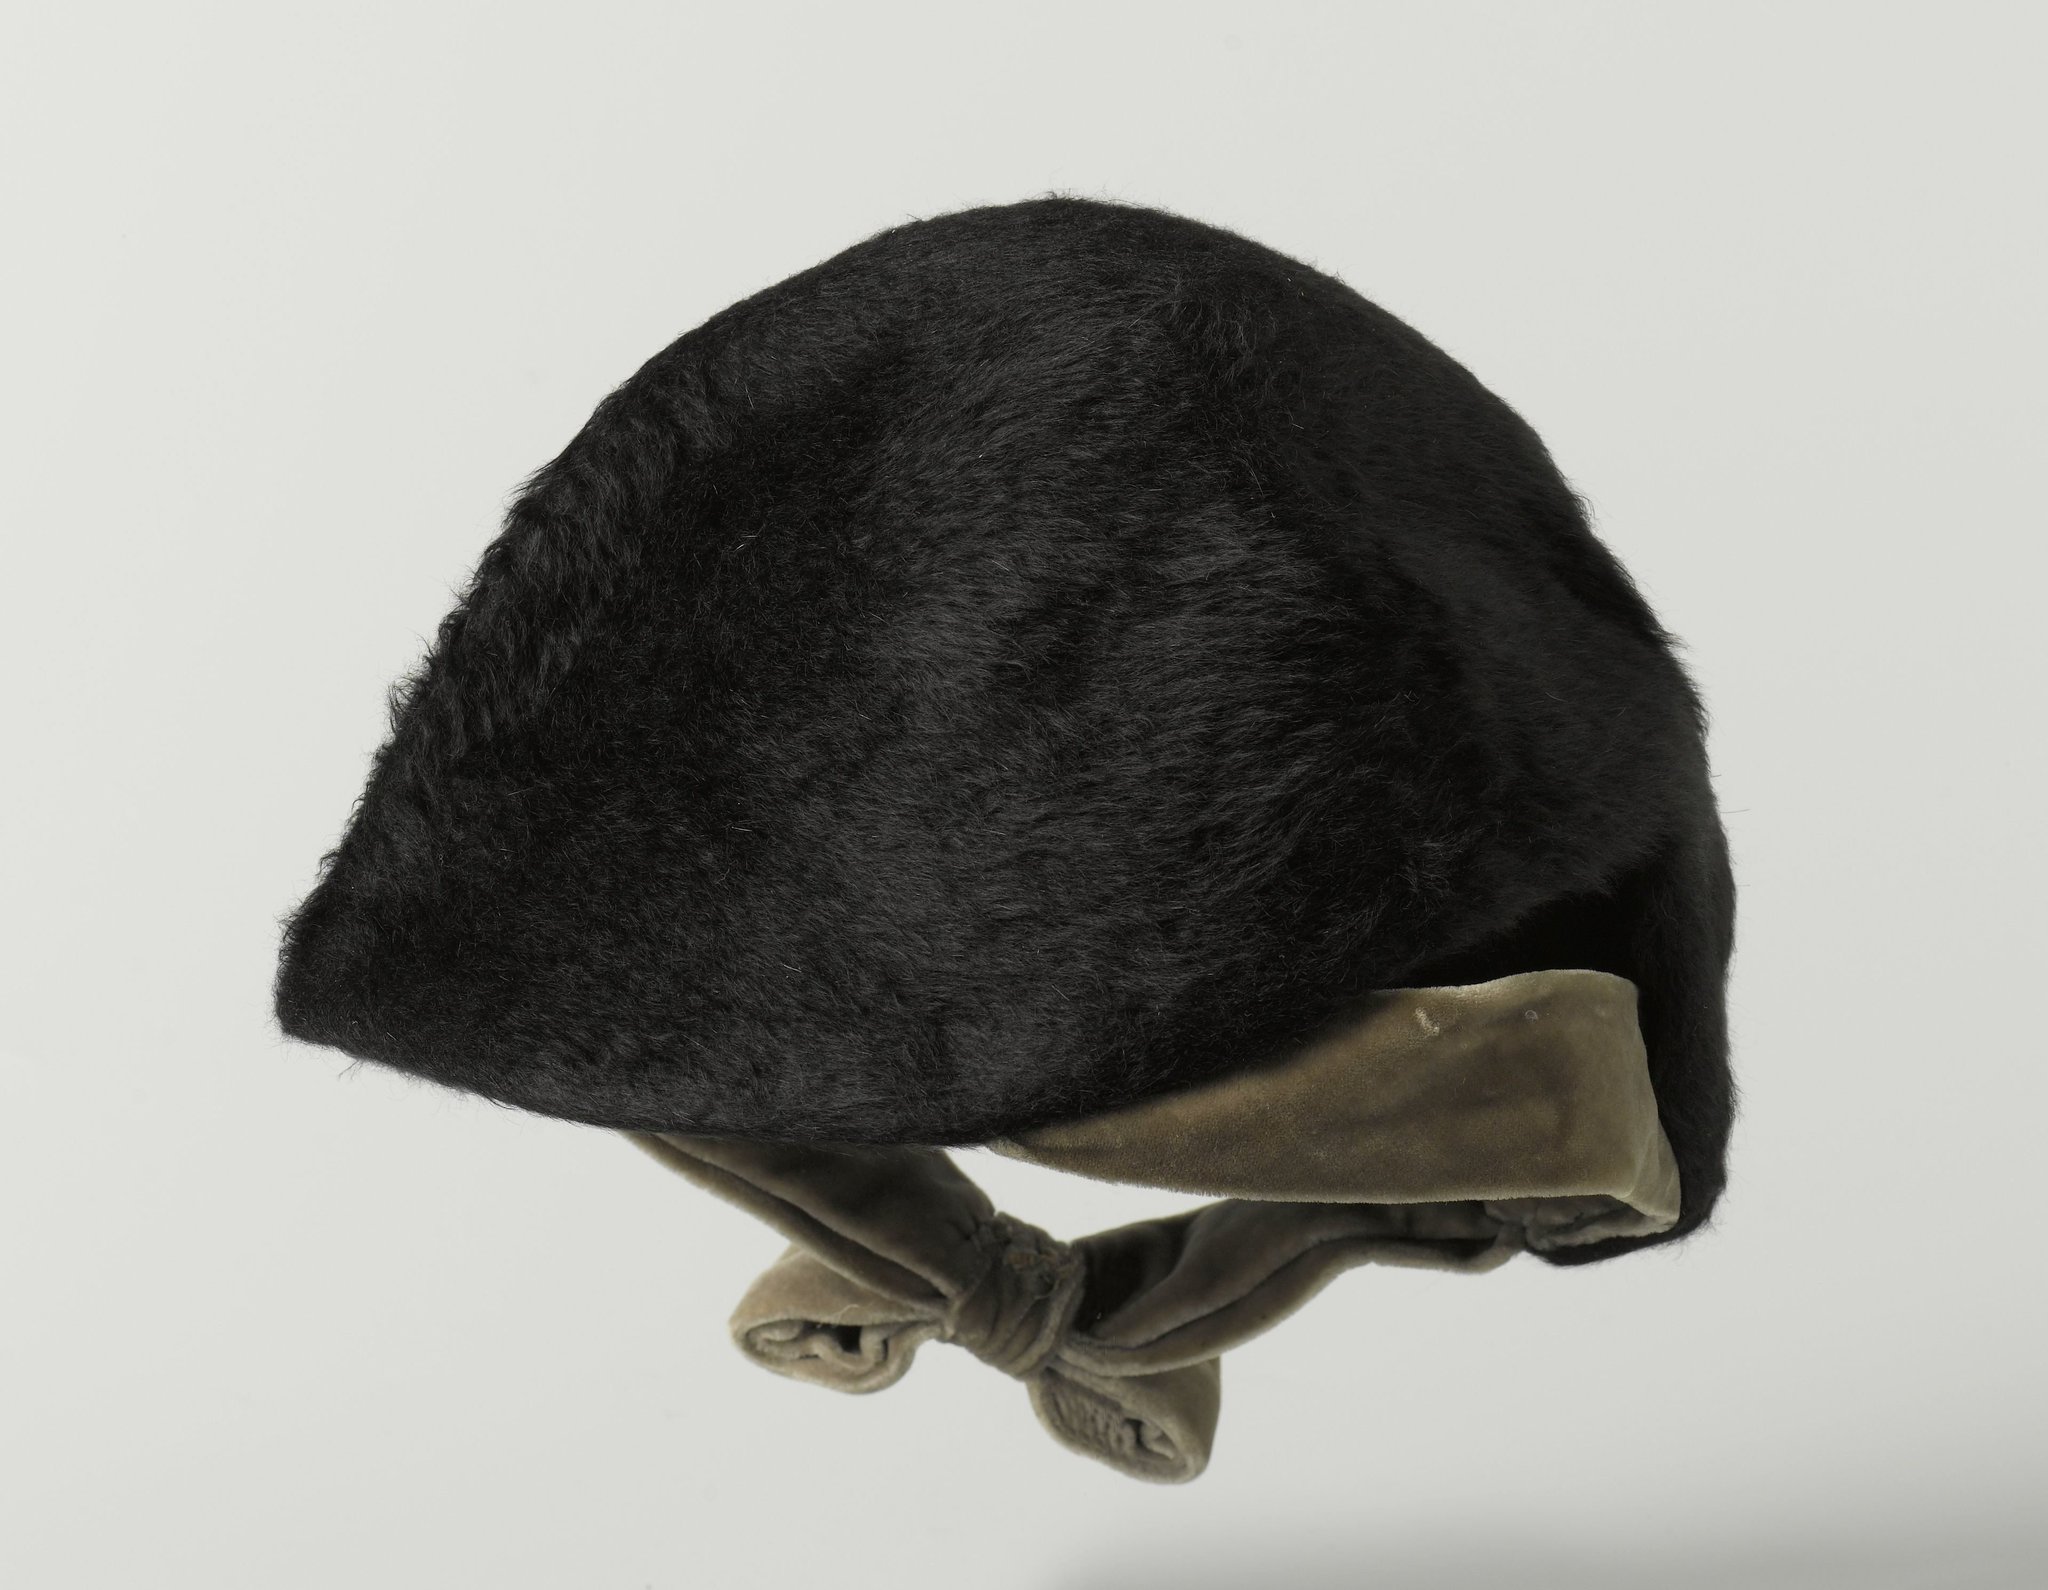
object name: hat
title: Puntig, asymmetrisch kapje van langharig zwart vilt en grijs fluweel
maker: caroline reboux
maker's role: modiste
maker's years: 1837-1927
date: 1949-1953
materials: felt, velvet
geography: paris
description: Puntig, asymmetrisch kapje van langharig zwart vilt en grijs fluweel. Met aan de binnenzijde een ingenaaid label waarop staat: Caroline Reboux/ 9 Avenue Matignon. Paris.